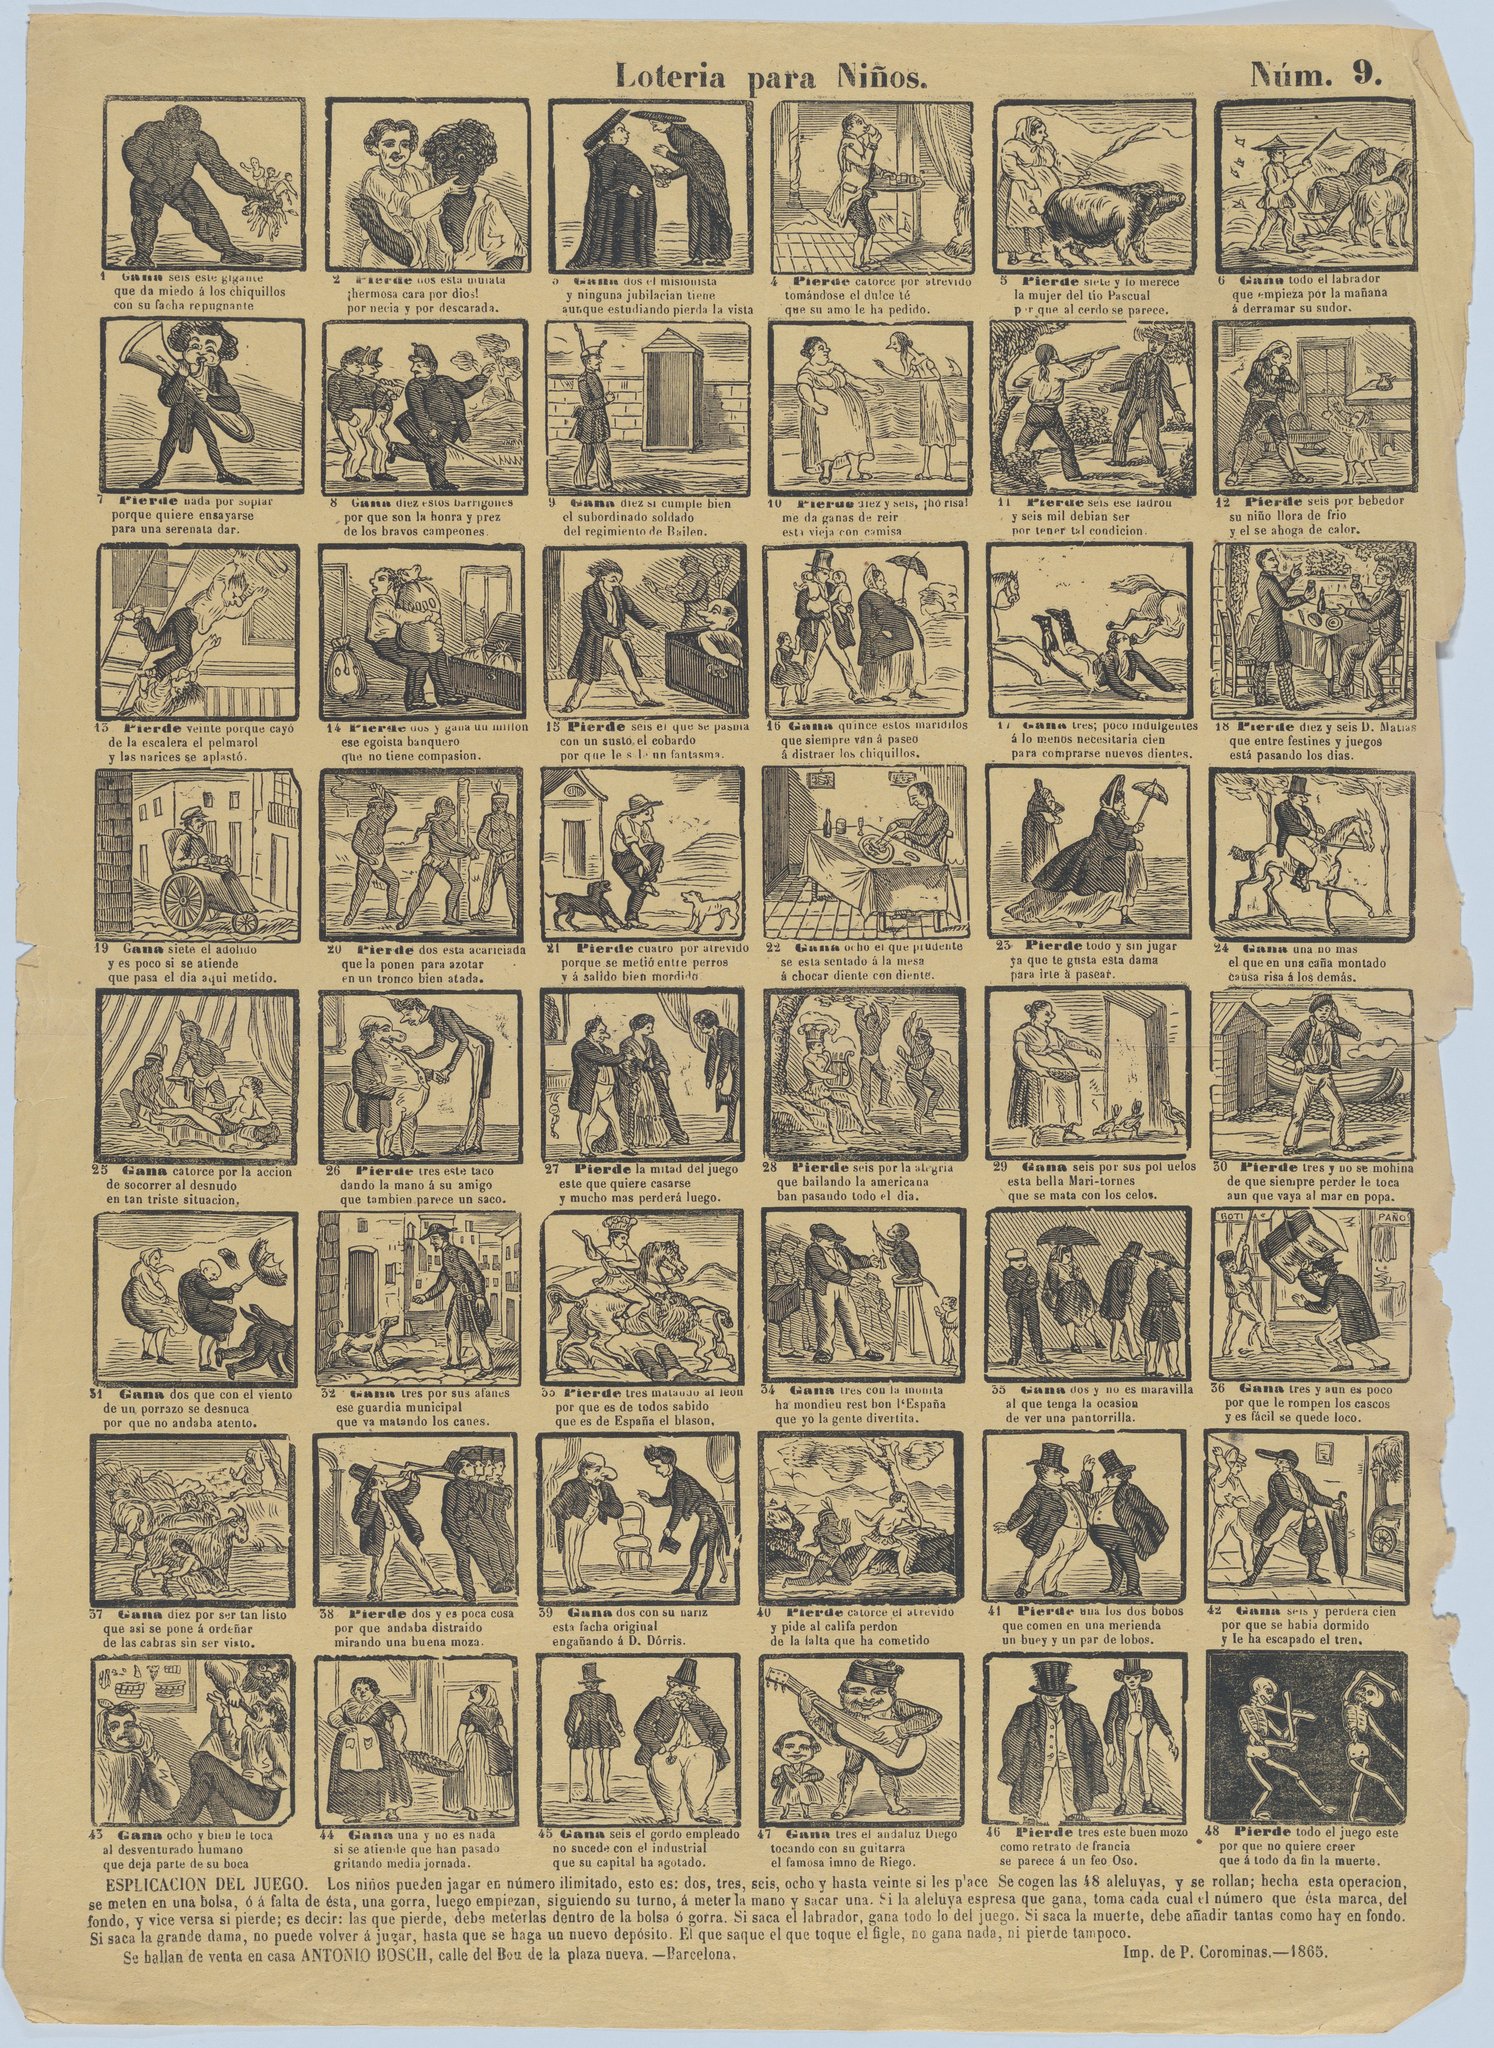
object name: print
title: A game for children with 48 scenes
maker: antonio bosch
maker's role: publisher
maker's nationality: spanish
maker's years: 1860-1880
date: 1865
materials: paper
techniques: printing, engraving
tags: musical instruments,animals,men,women